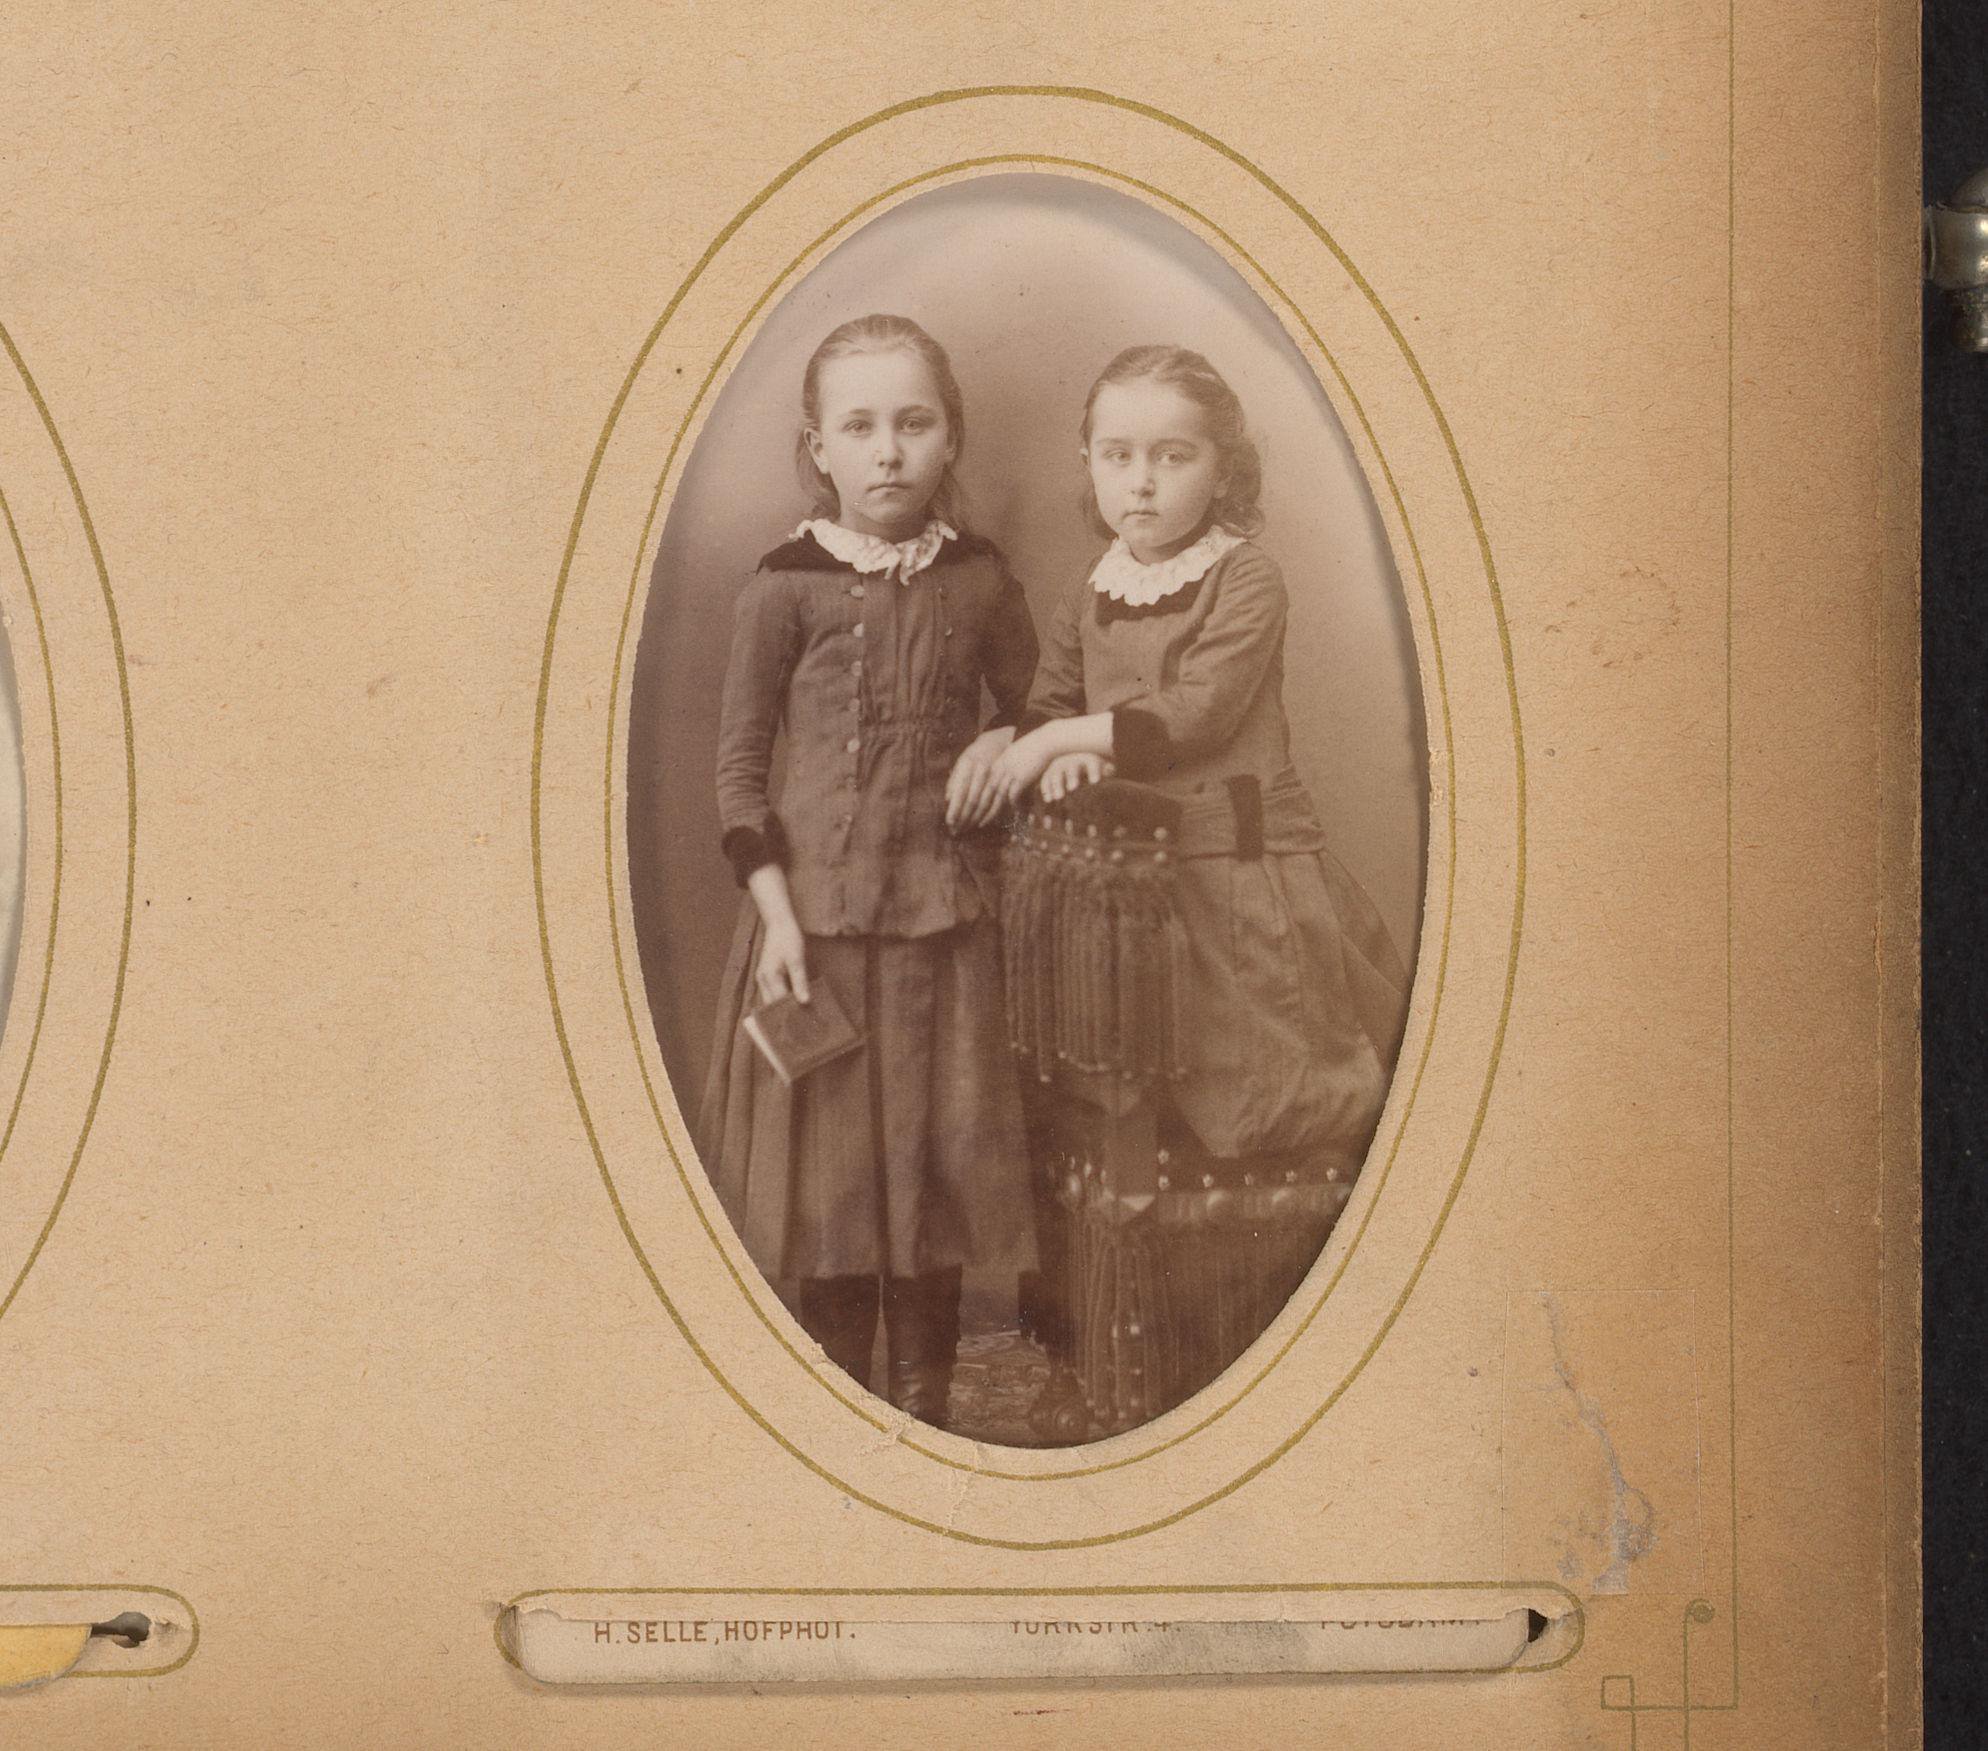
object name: album leaf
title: Portret van twee meisjes, waarvan één staand met boek in de hand en één knielend op een bidstoel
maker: hermann selle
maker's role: fotograaf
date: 1862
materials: cardboard, photographic support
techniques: albumen print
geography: potsdam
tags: kneeling-chair, historical persons - bb - woman, book, girl (child between toddler and youth) (+ two persons)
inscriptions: inscription: ‘Hermann Selle/ Hof-Photograph/ Sr. Maj. d. Kaisers u. Königs/ Sr. Kaisel. u Königl. Hoh. d. Kronprinzen/ u. dr. Königl. Hoh. d. Prinzen Wilhelm von Preussen./ 4. York-Strasse 4,/ Potsdam.’